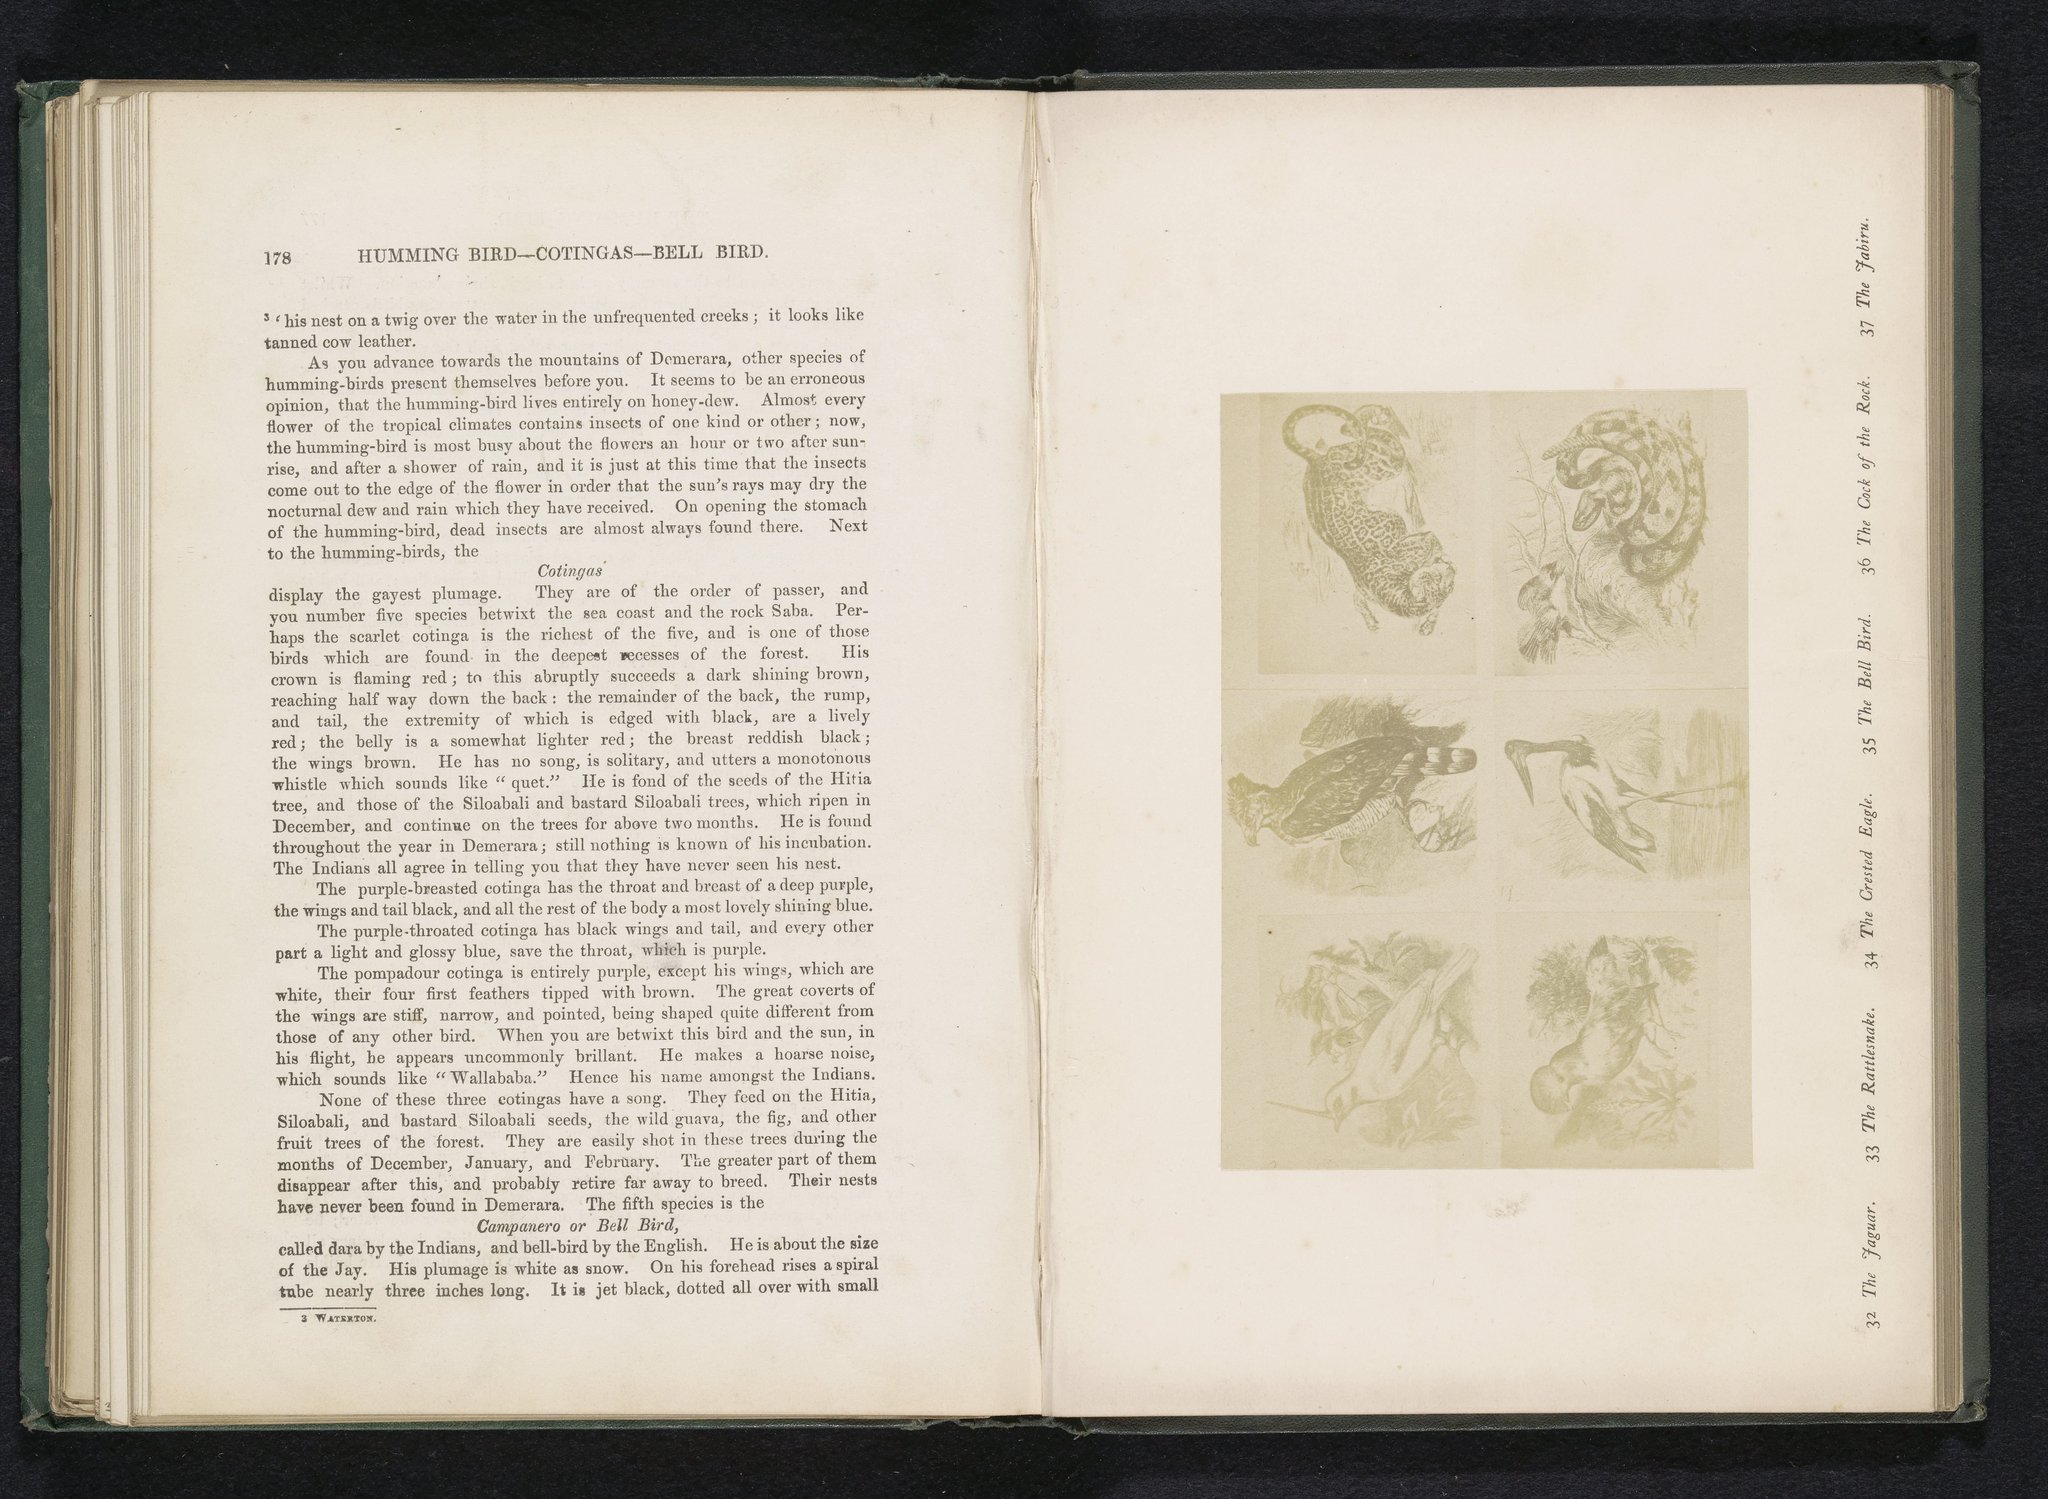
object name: page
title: The Jaguar. The Rattlesnake. The Crested Eagle. The Bell Bird. The Cock of the Rock. The Jabiru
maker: Anonymous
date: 1856-1866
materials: photographic support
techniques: albumen print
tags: snakes, birds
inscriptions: number: ‘32 33 34 35 36 37’